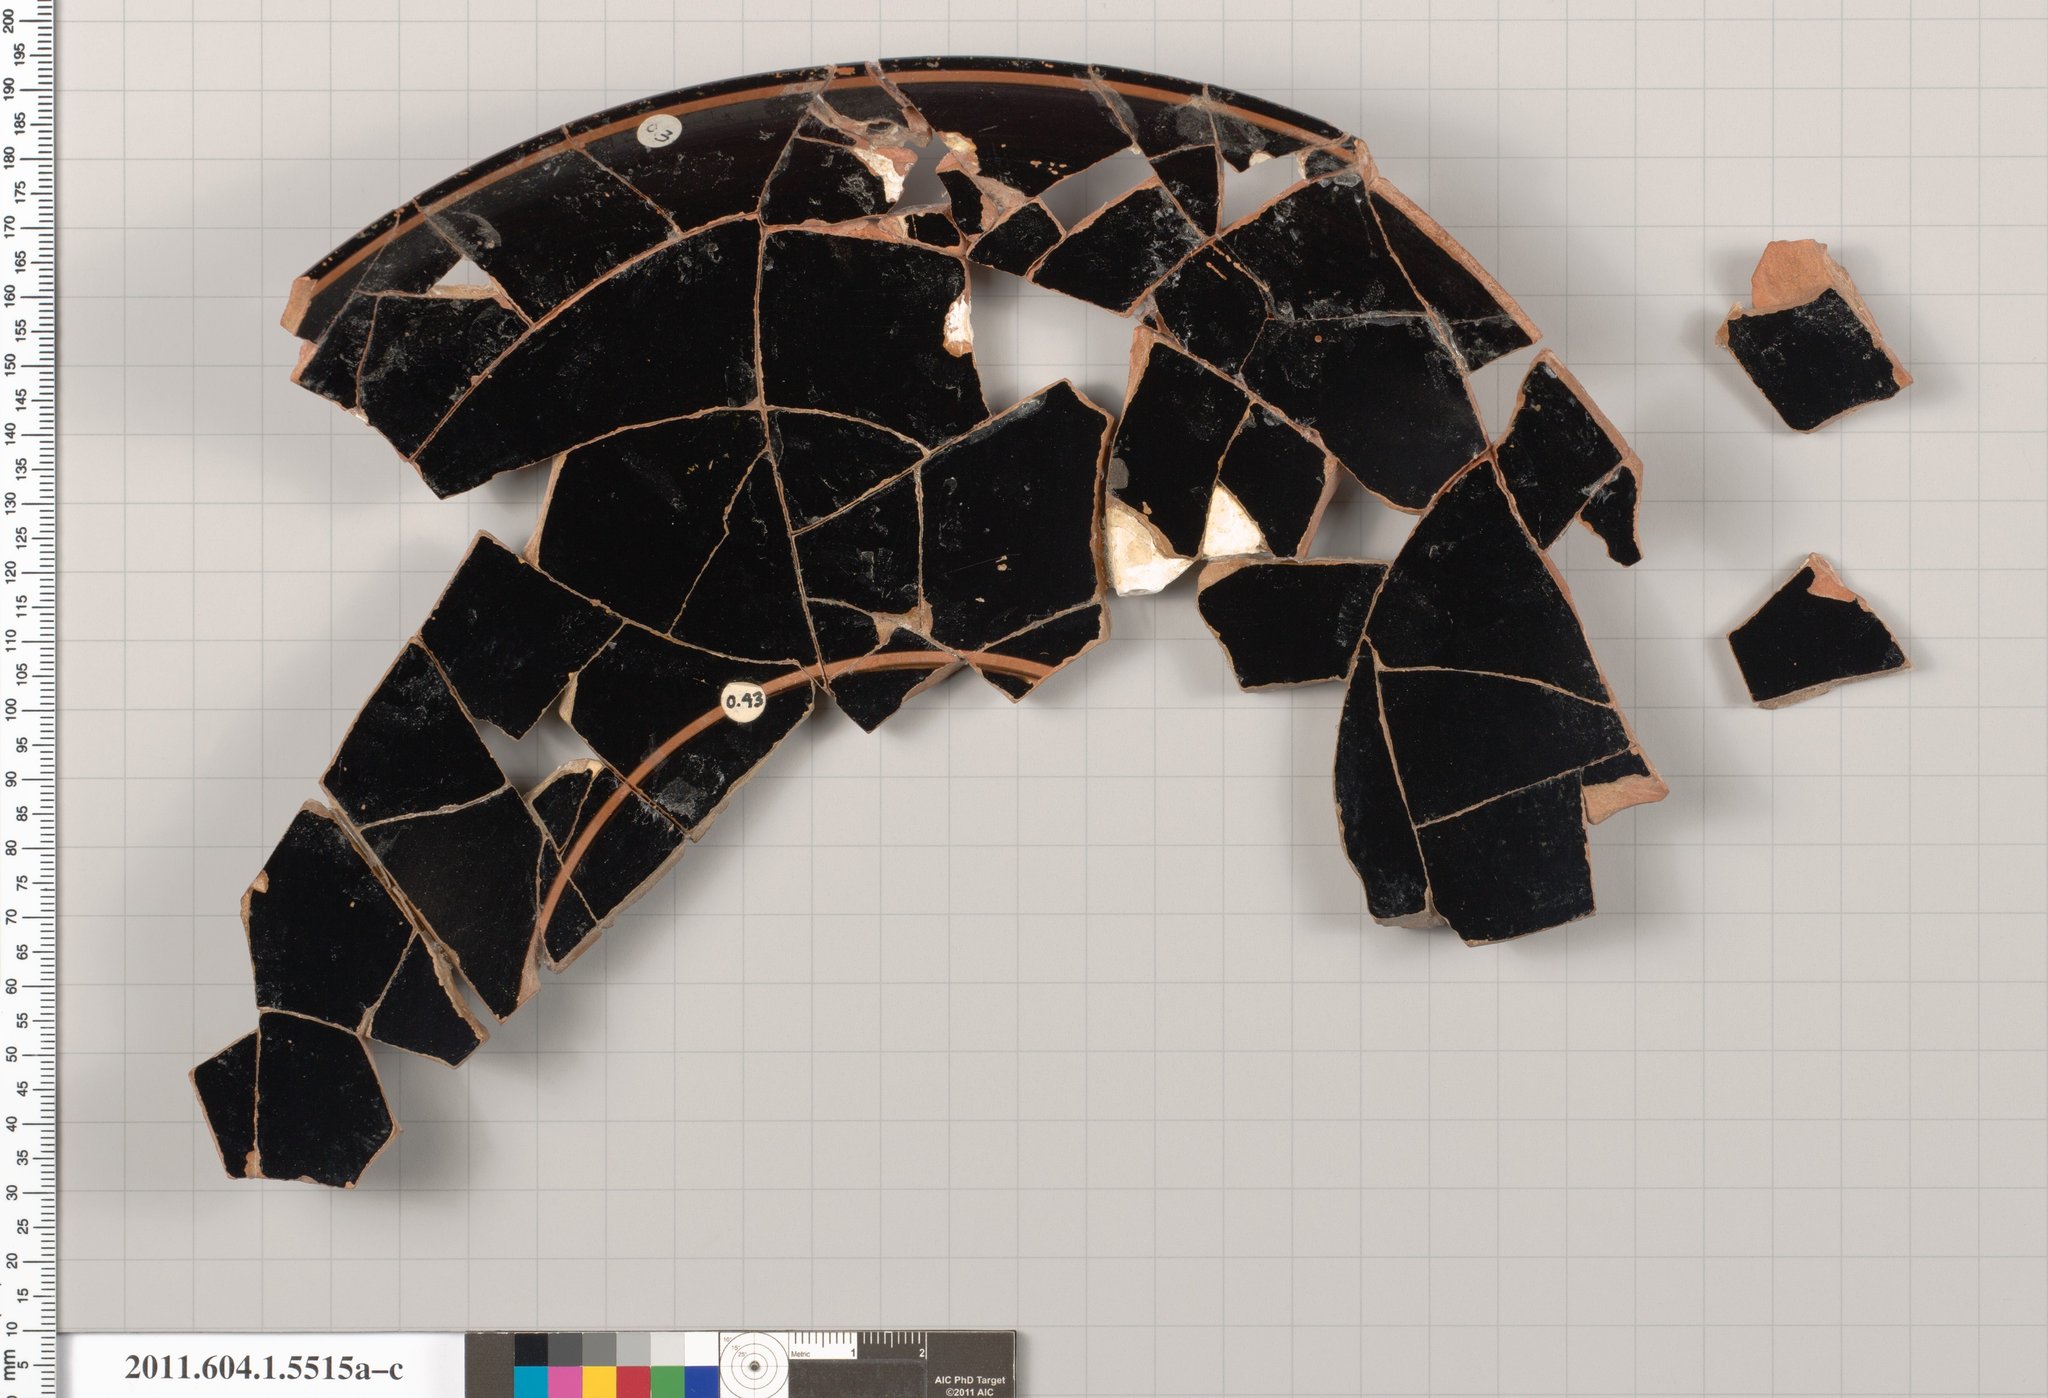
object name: kylix fragment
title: Terracotta fragments of a kylix (drinking cup)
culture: greek, attic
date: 520-510 BCE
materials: terracotta